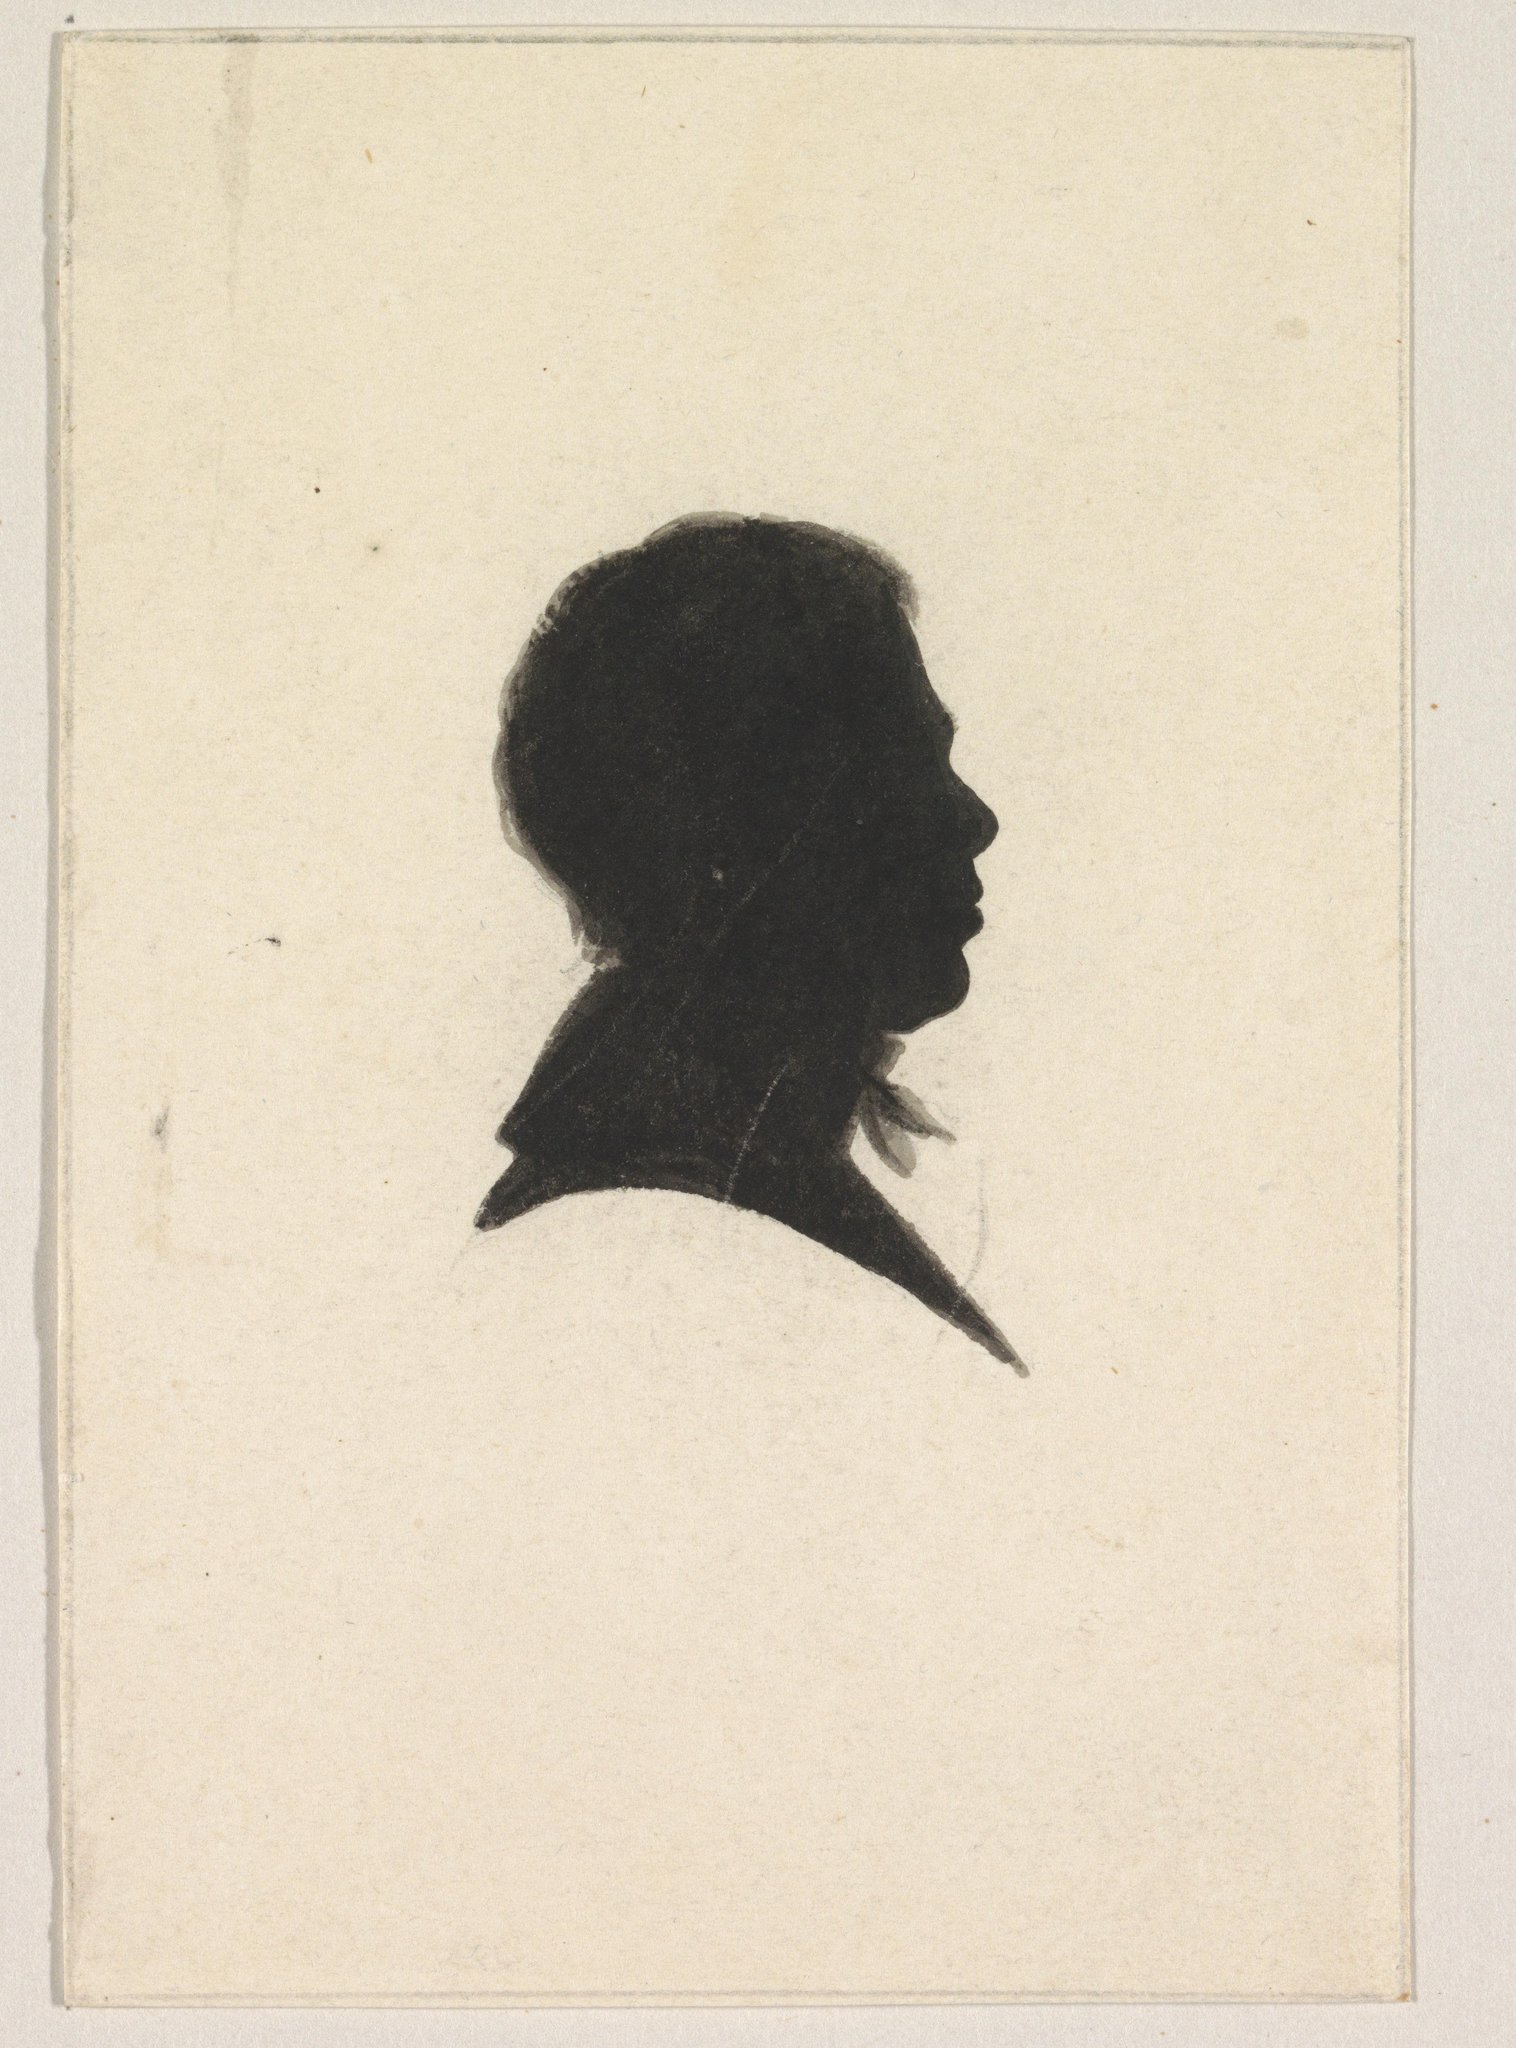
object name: drawing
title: Silhouet van een man, naar rechts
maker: jan willem caspari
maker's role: print maker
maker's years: 1779-1822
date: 1789-1822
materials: paper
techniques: brush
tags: anonymous historical person portrayed, male sex; man